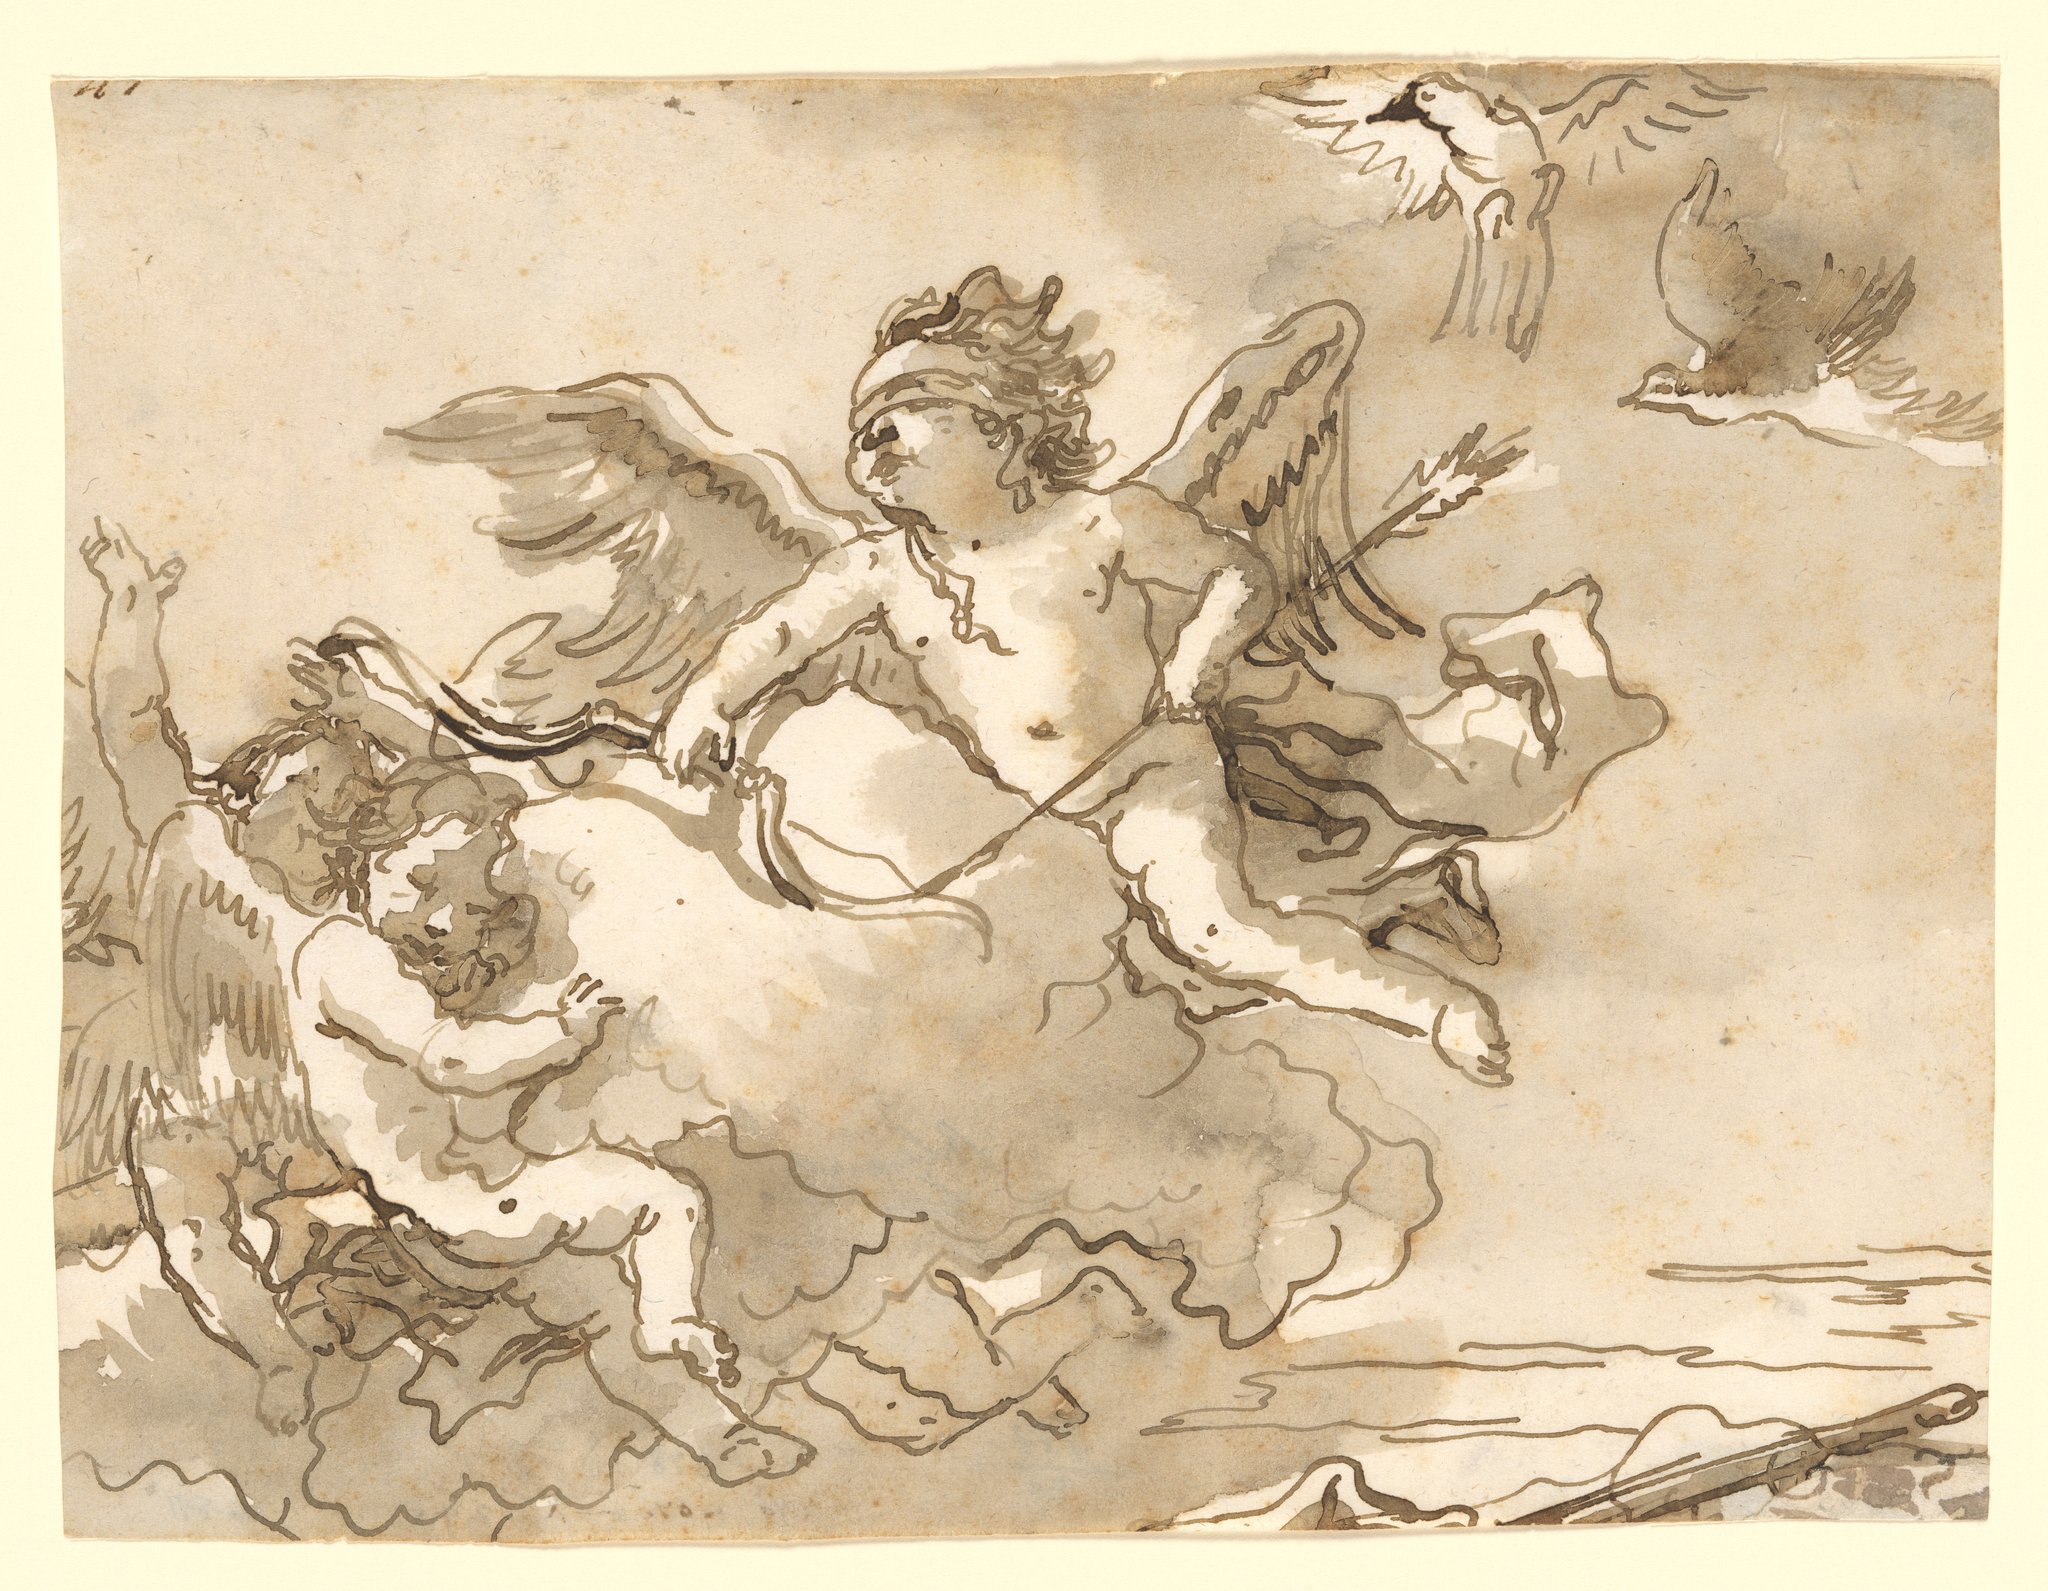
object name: drawing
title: Cupid Blindfolded, on a Cloud Supported by Two Attendant Putti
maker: giovanni domenico tiepolo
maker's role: artist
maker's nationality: italian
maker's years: 1727-1804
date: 1770-1790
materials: ink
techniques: pen, wash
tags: cupid,putti